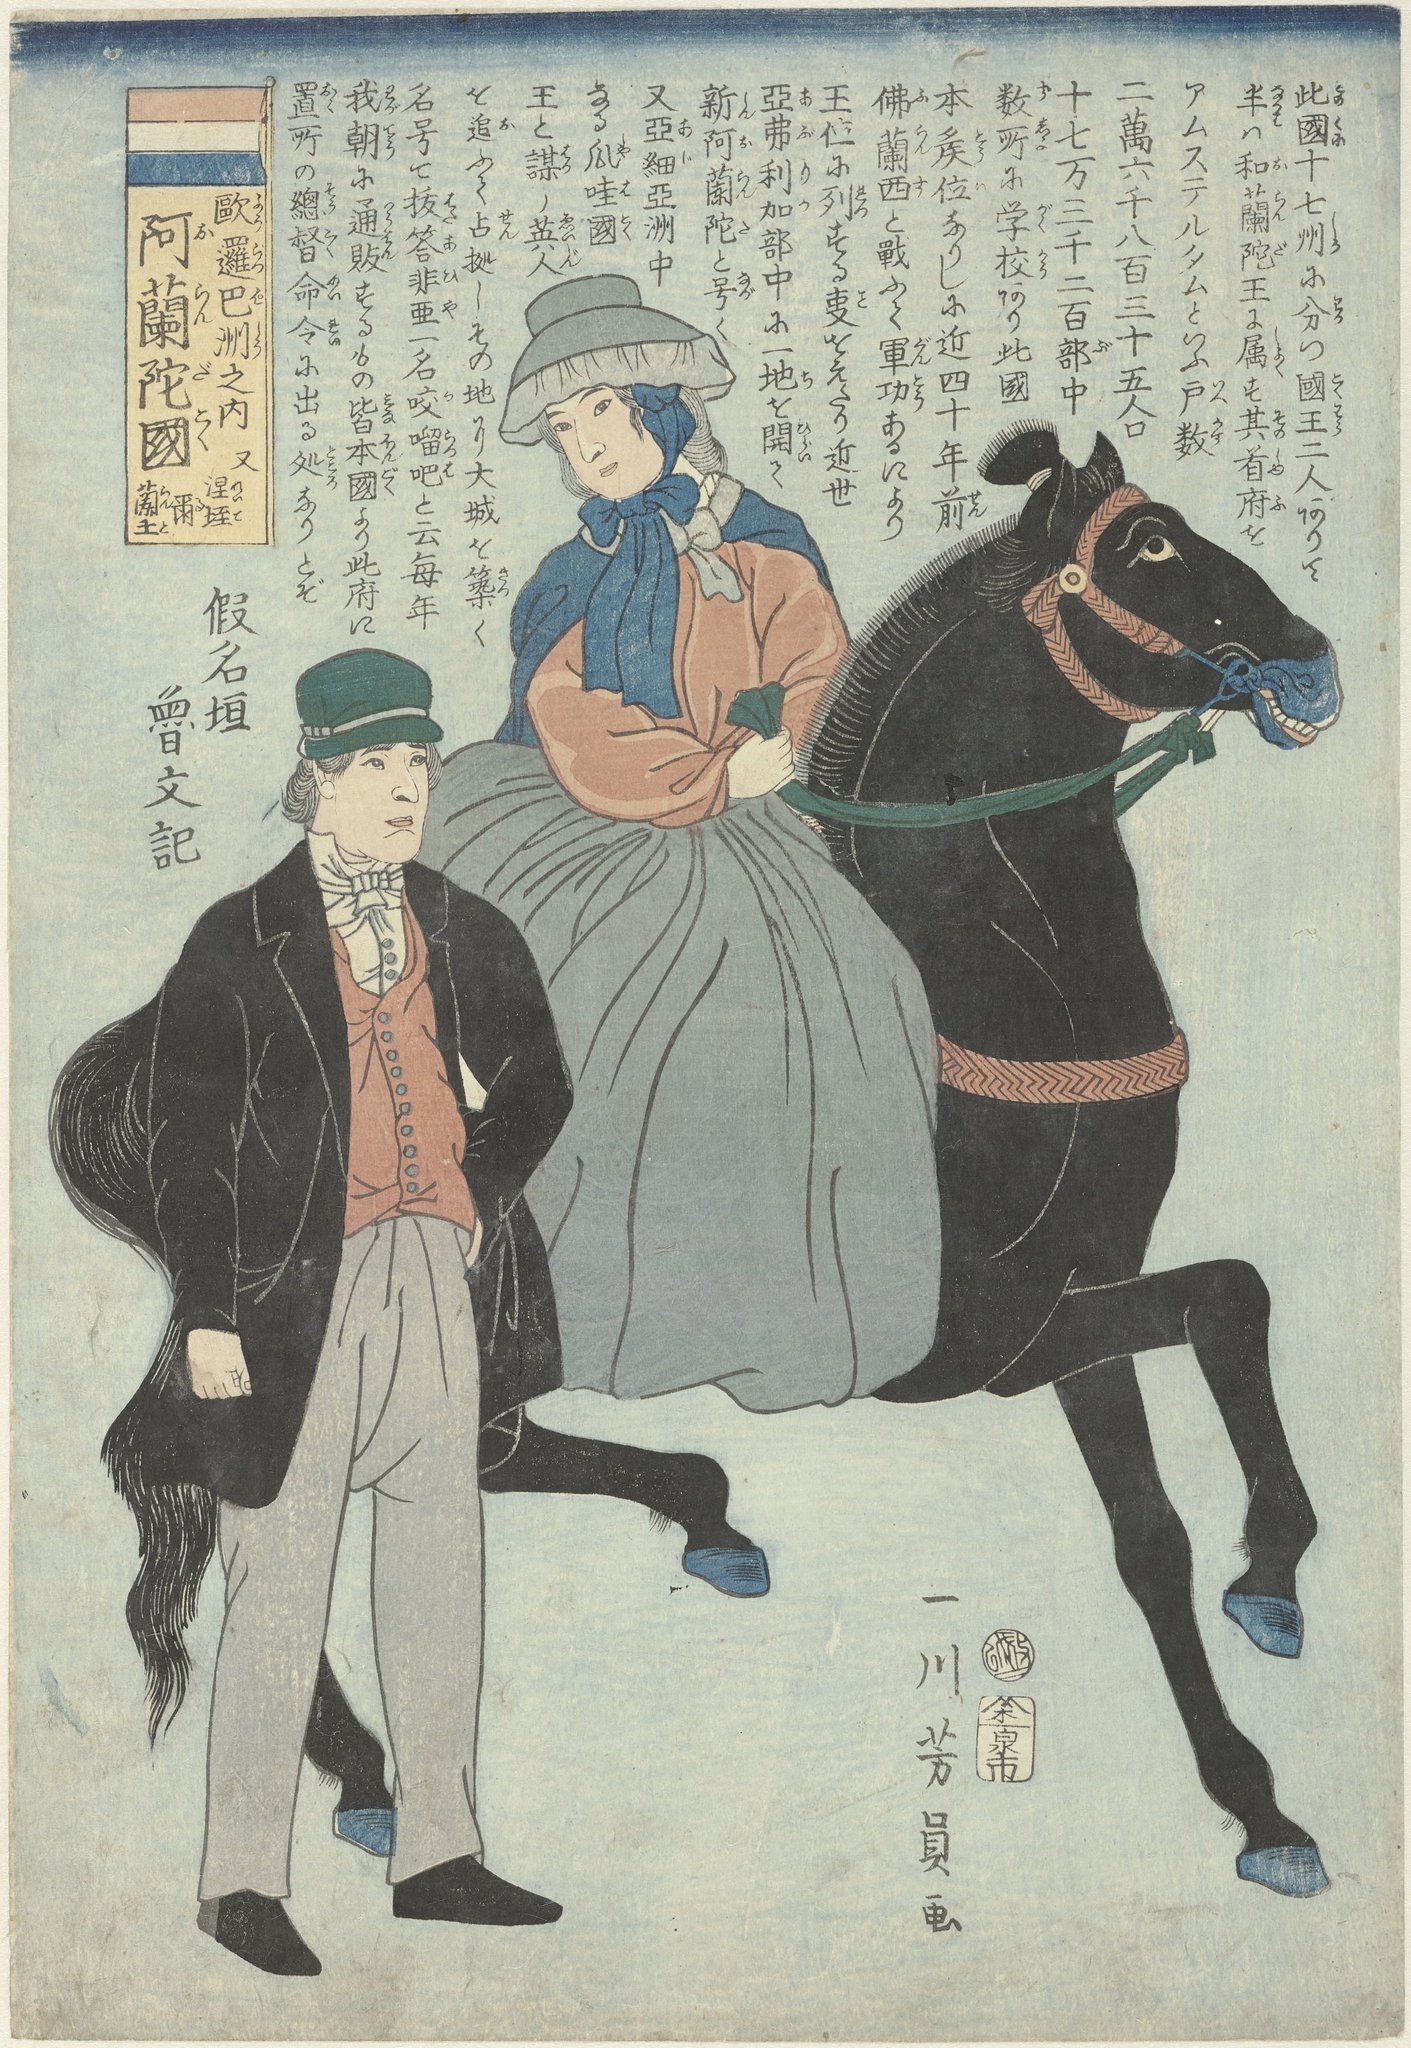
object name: print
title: Nederlands stel, waarvan de vrouw te paard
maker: utagawa yoshikazu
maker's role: print maker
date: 1802-1862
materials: paper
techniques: woodcut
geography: japan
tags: riding a horse, ass, or mule; rider, horseman, europeans (with name)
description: Een vrouw te paard, naast een staande man. Op de achtergrond Japanse tekst. (Yokohama-e).